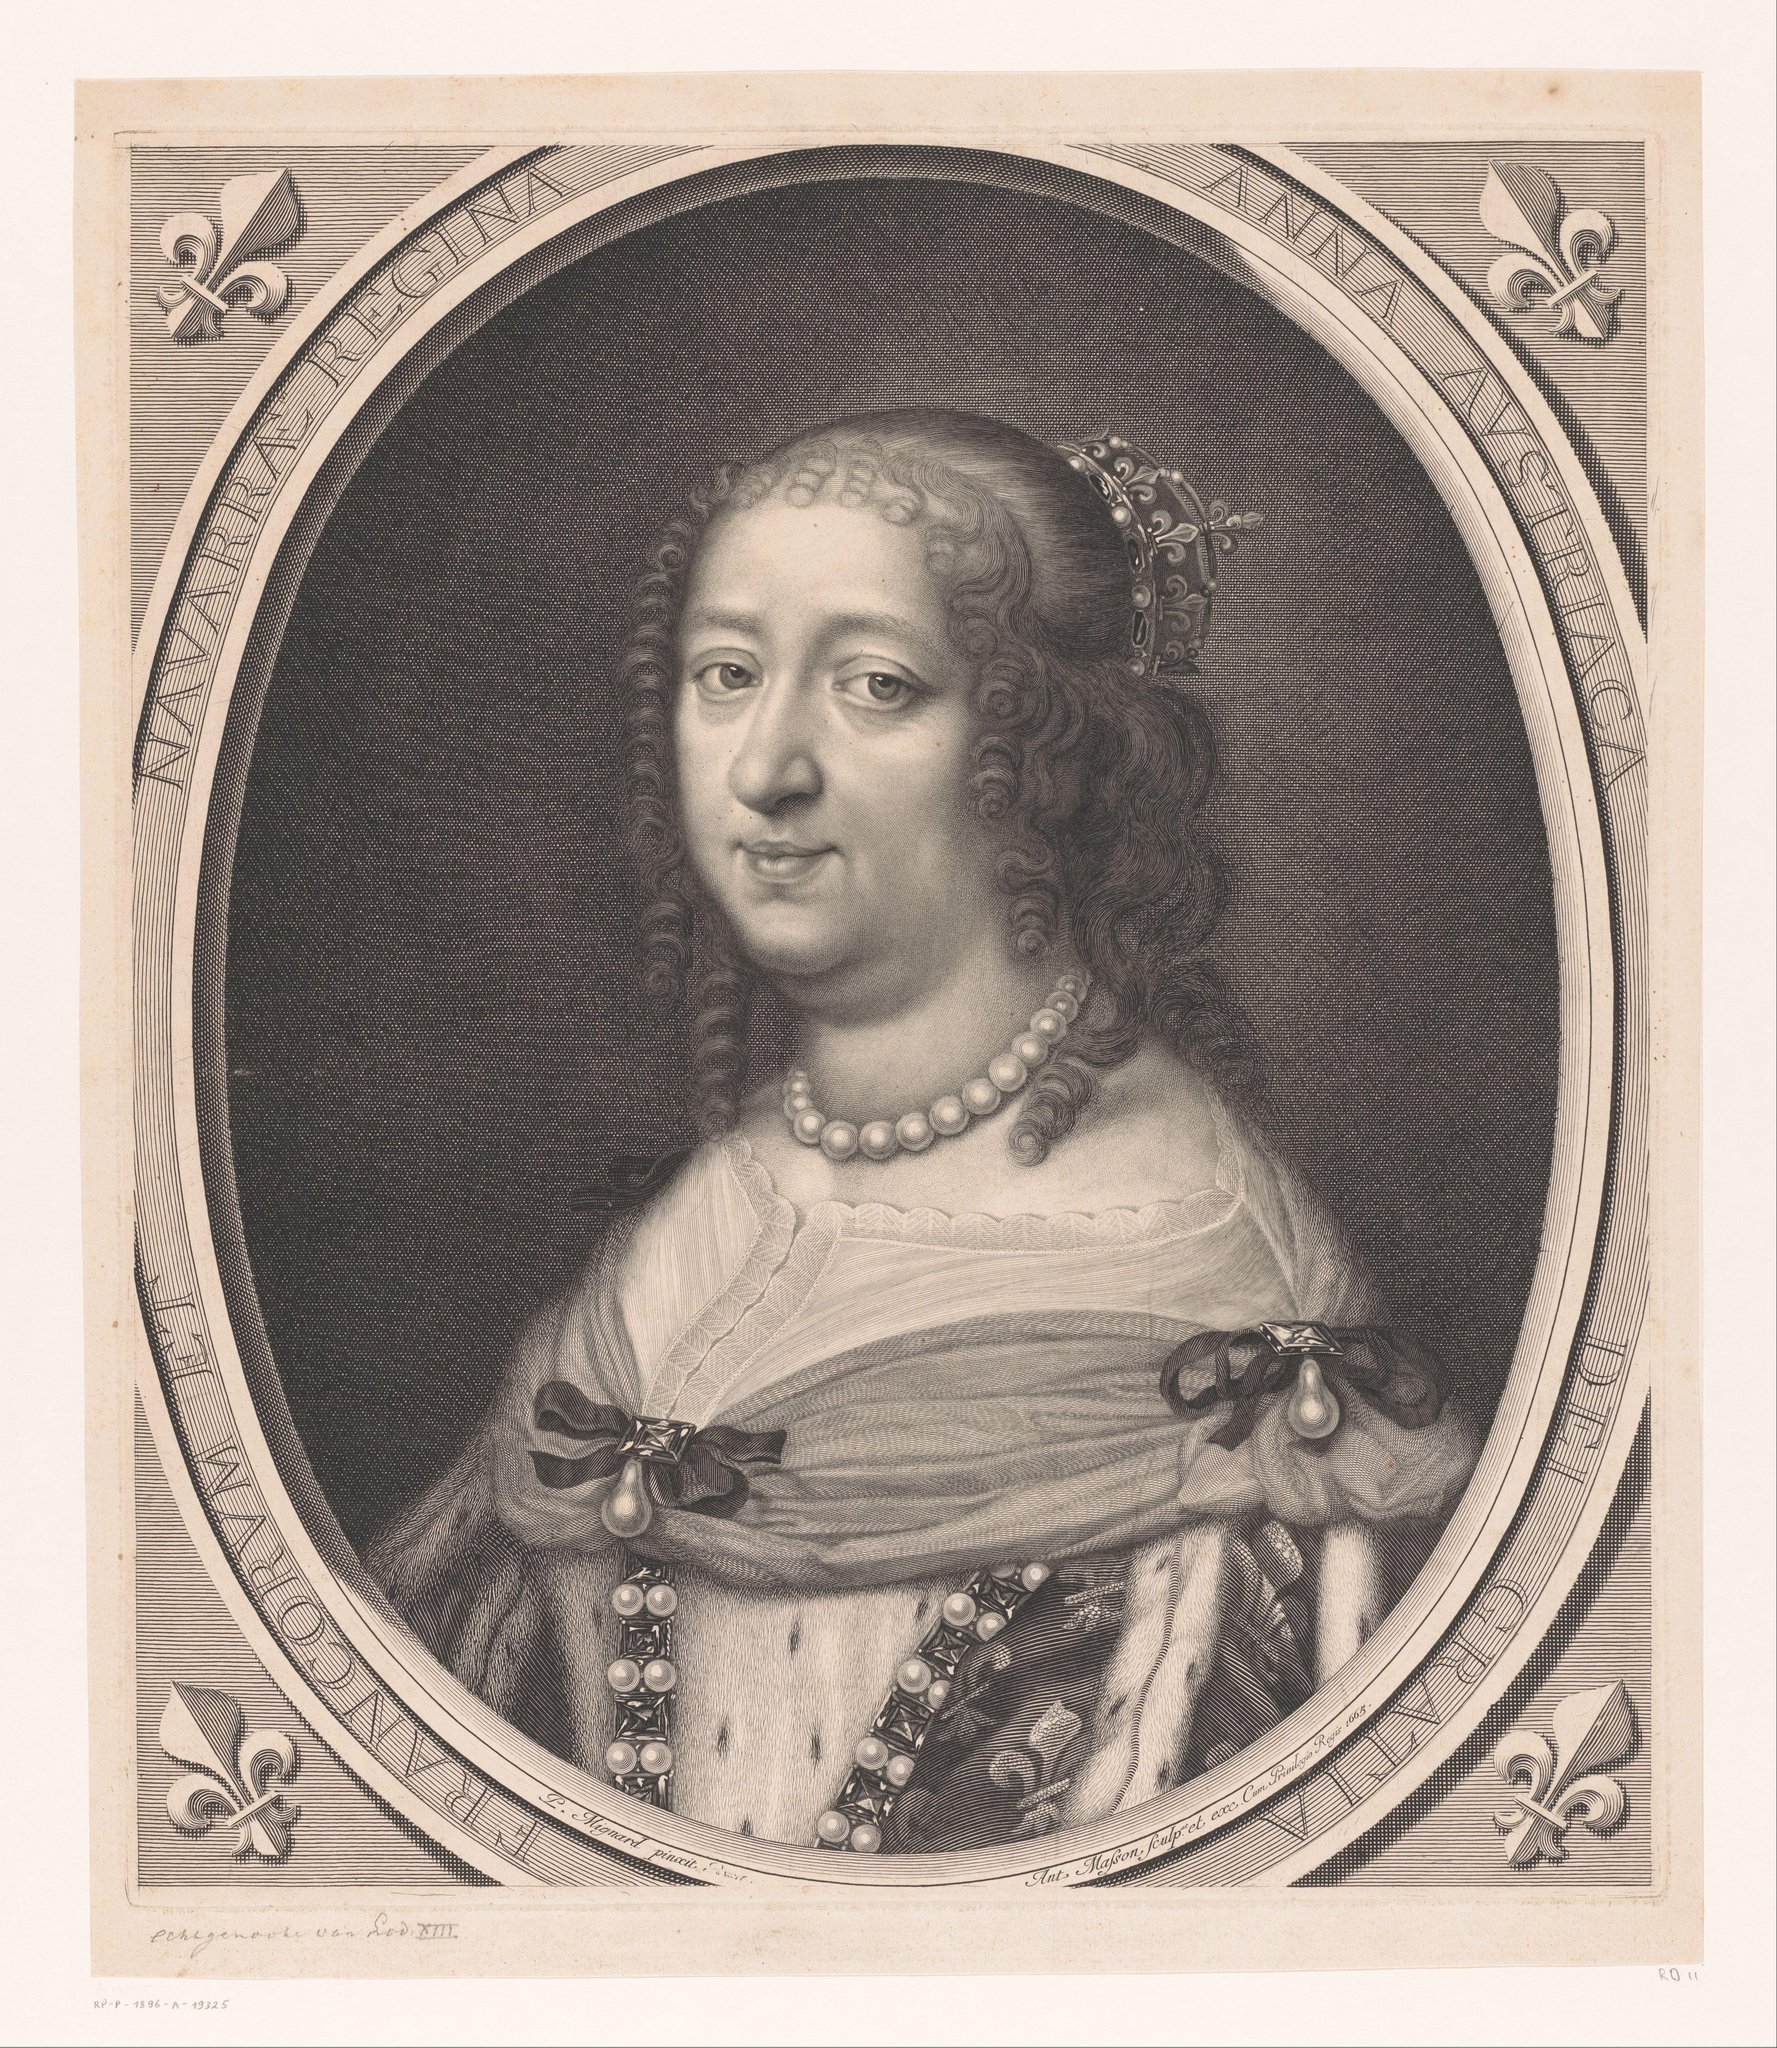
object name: print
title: Portret van Anna van Oostenrijk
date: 1665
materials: paper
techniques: engraving, etching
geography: france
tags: anna van oostenrijk (koningin van frankrijk), historical persons - bb - woman, queen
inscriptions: collector's mark: Lugt 2228